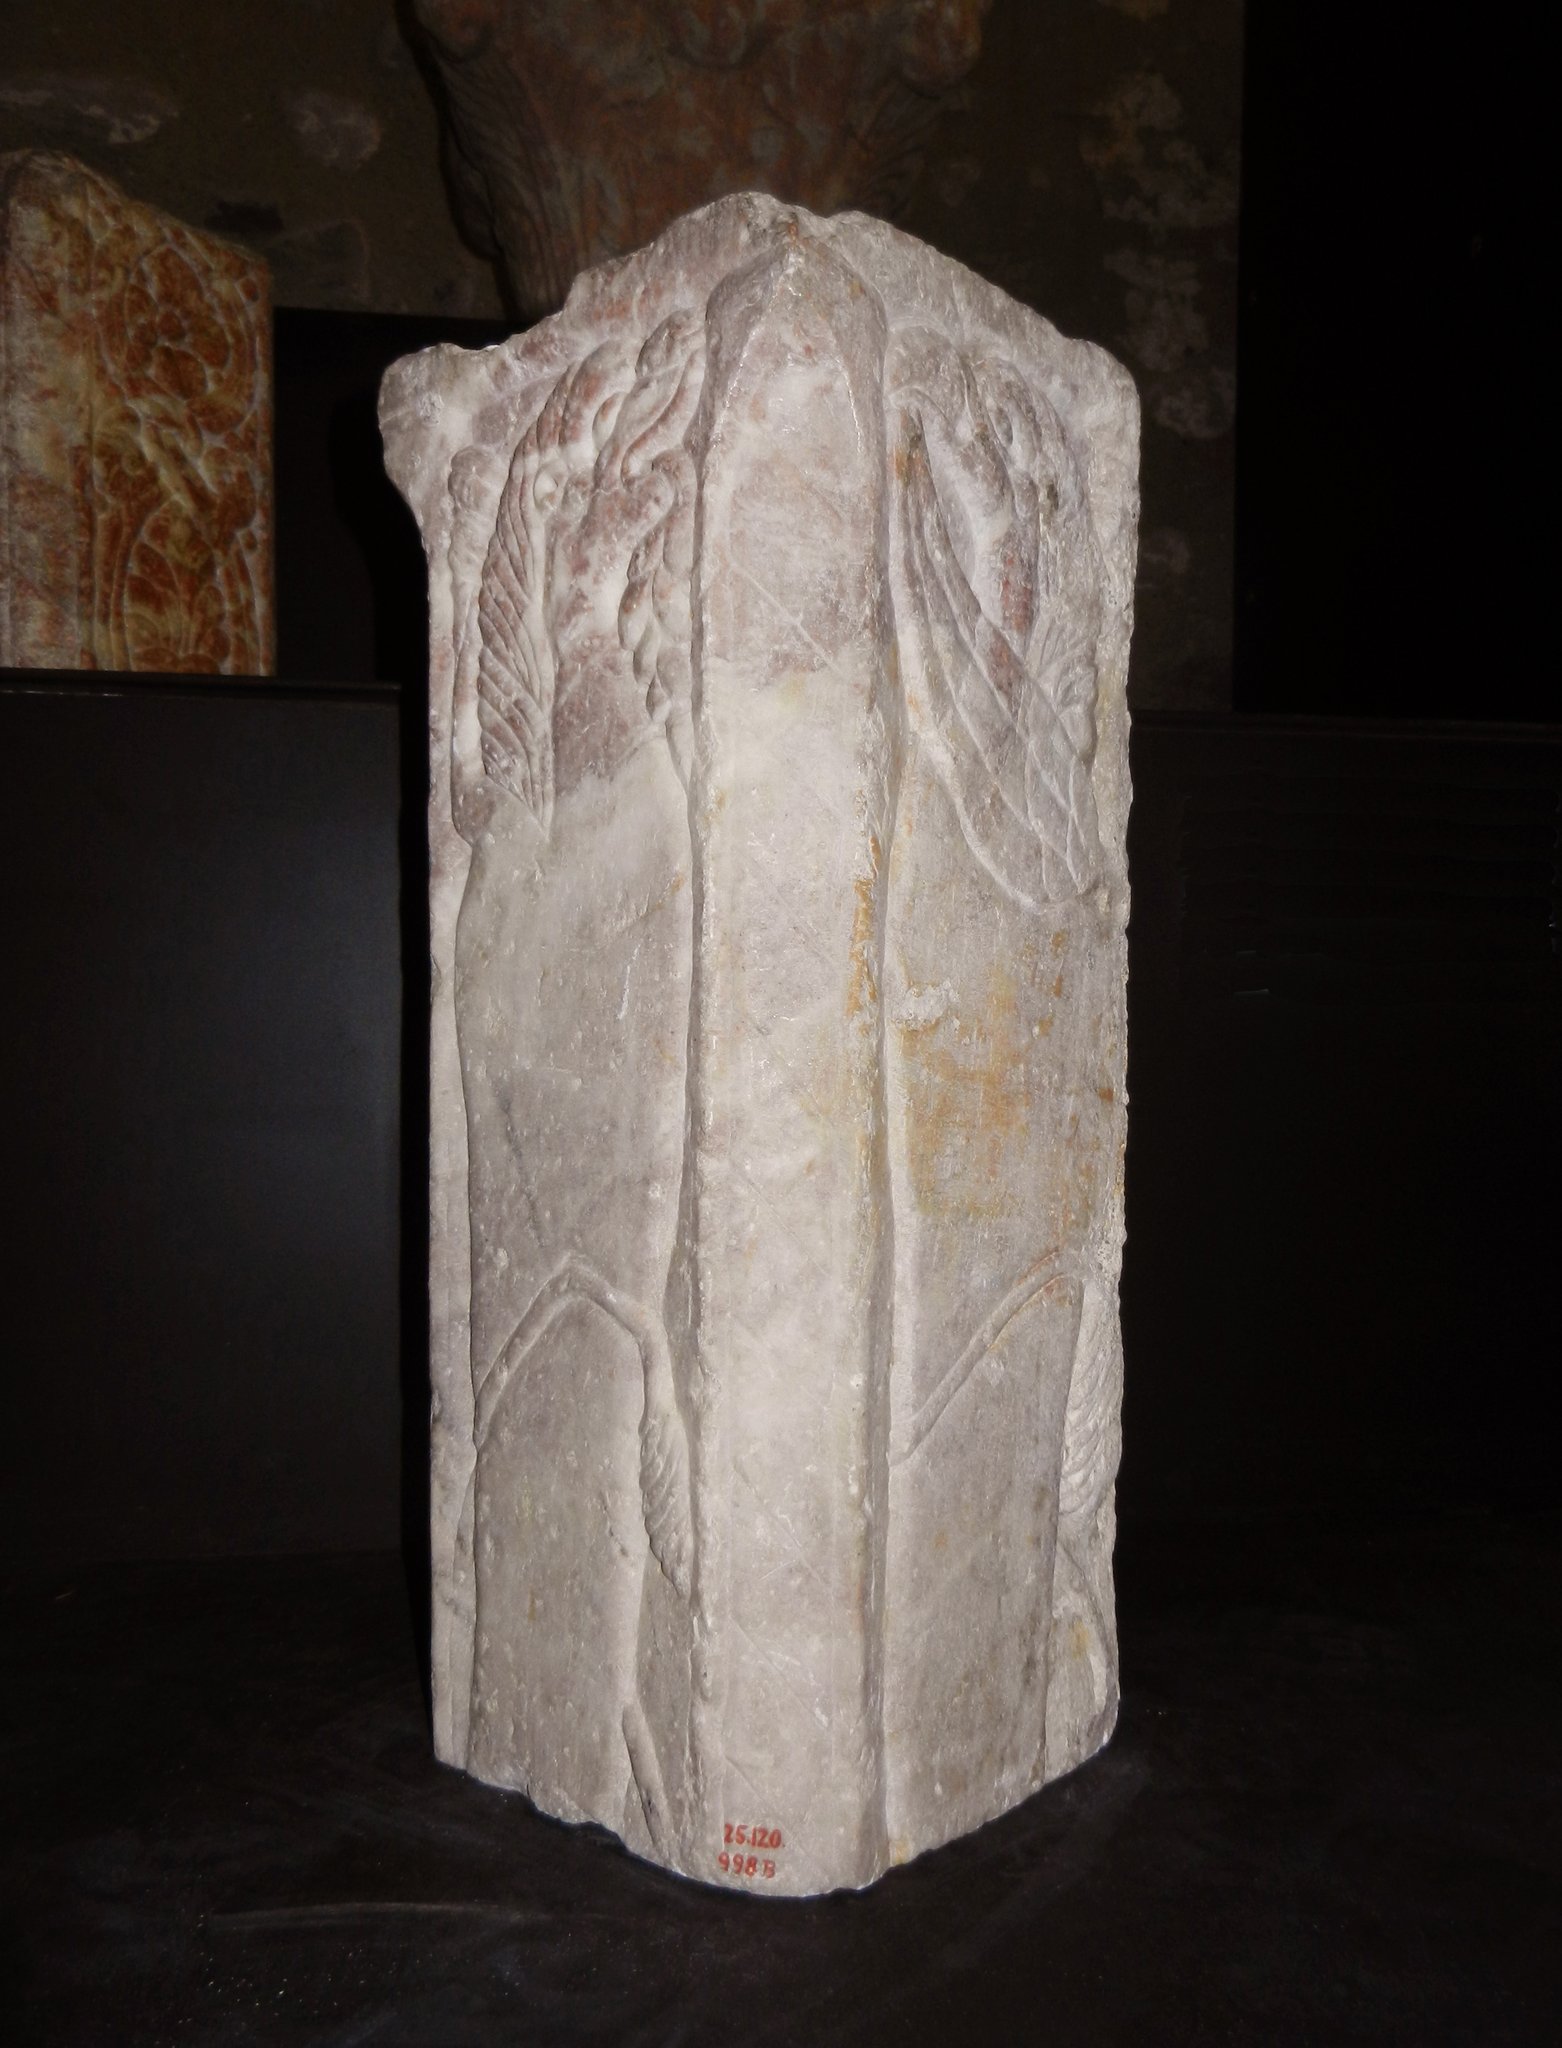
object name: block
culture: catalan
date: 1130-1140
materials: marble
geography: france